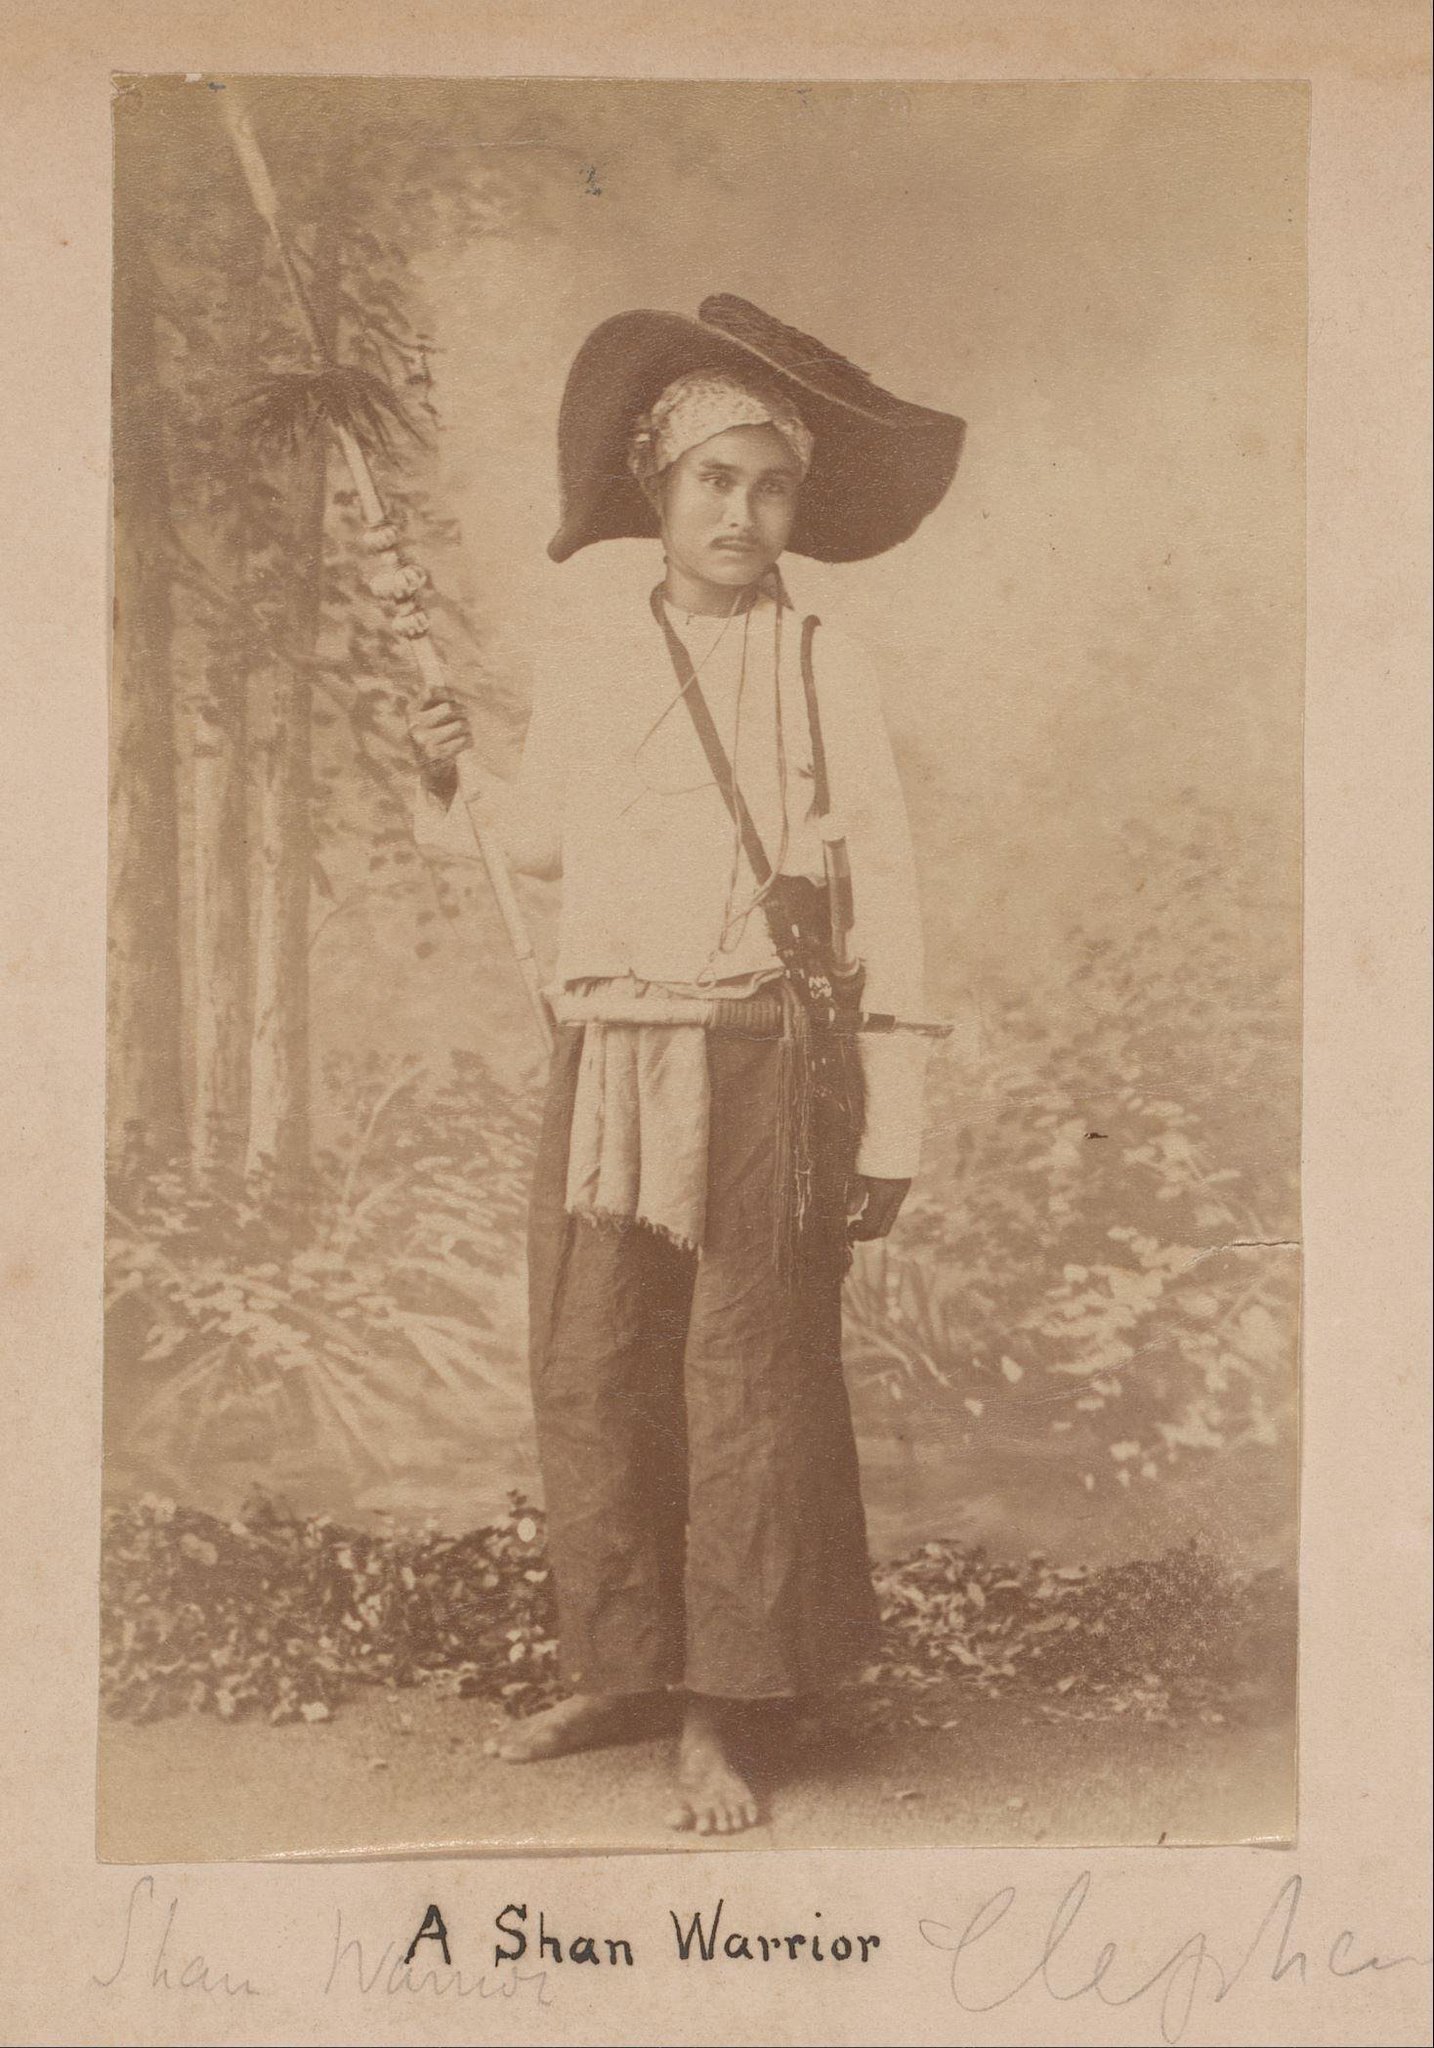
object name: album leaf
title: Portrait of a Shan warrior, Myanmar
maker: Anonymous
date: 1870-1900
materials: cardboard, paper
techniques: albumen print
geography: myanmar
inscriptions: caption: ‘A Shan Warrior’, caption: ‘Shan Warrior’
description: Portret ten voeten uit van een Shan-krijger tegen een geschilderde achtergrond.